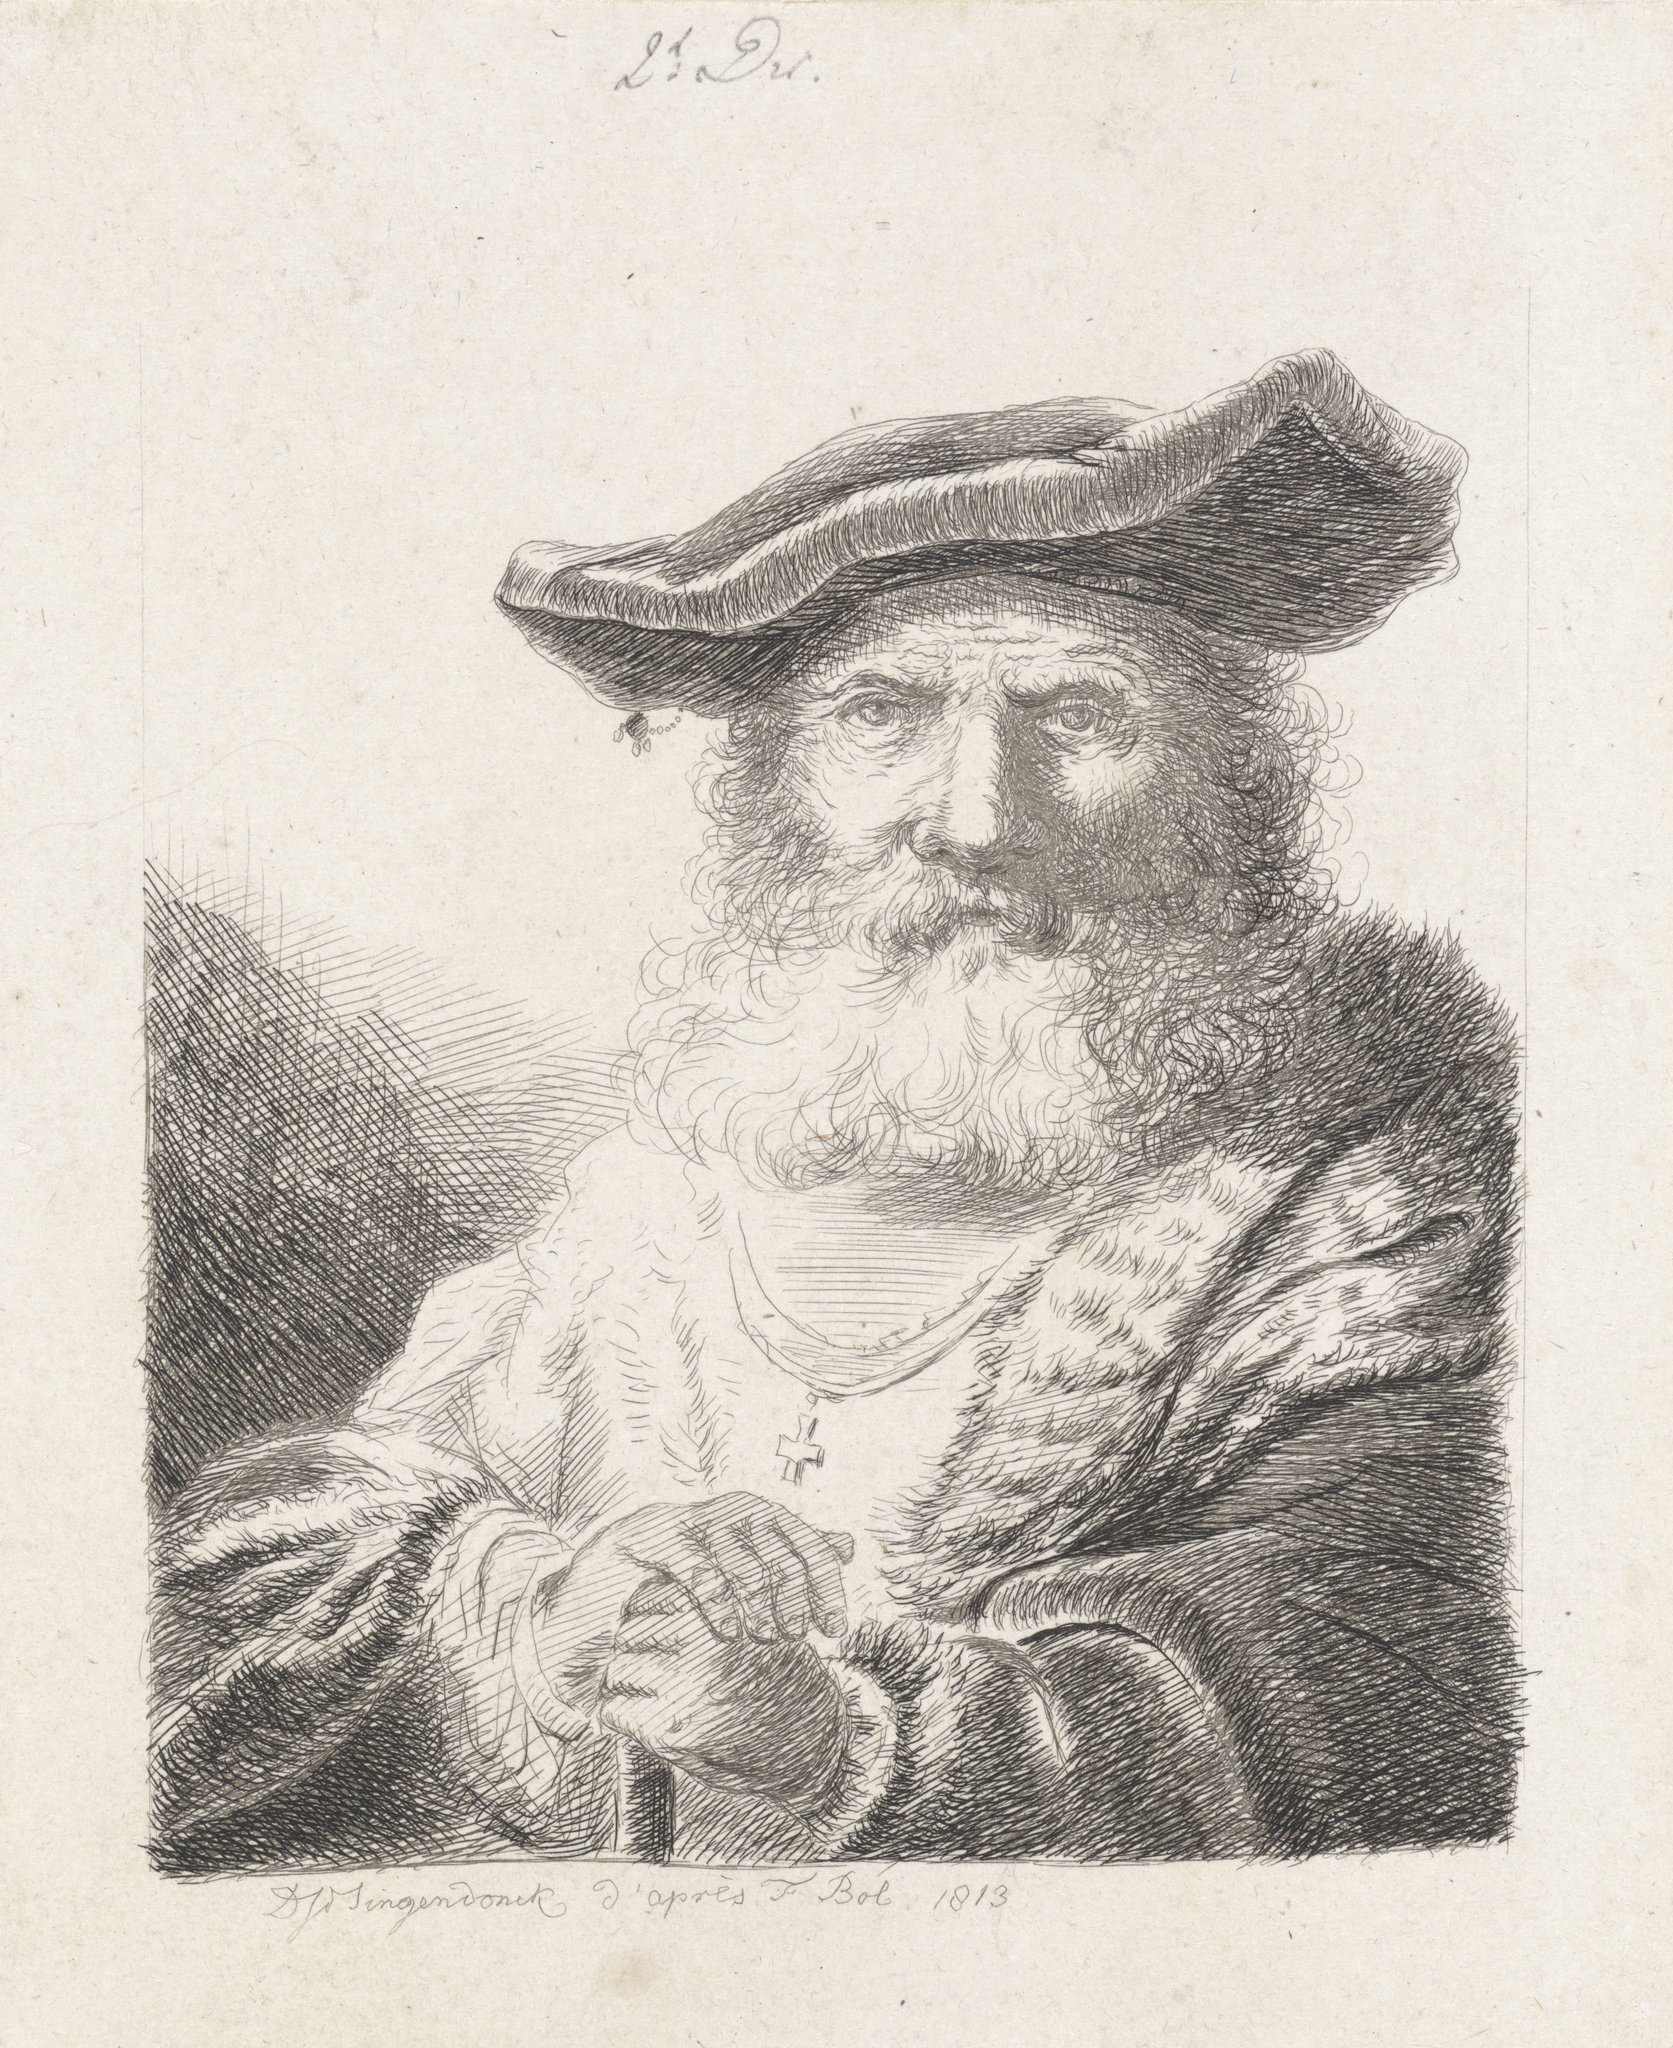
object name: print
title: Oude man met baret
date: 1813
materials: paper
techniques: etching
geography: utrecht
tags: old man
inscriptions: collector's mark: Lugt 2228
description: Oude man met baret. Om zijn hals draagt hij een lint met een klein kruis. Zijn handen rusten op een stok.